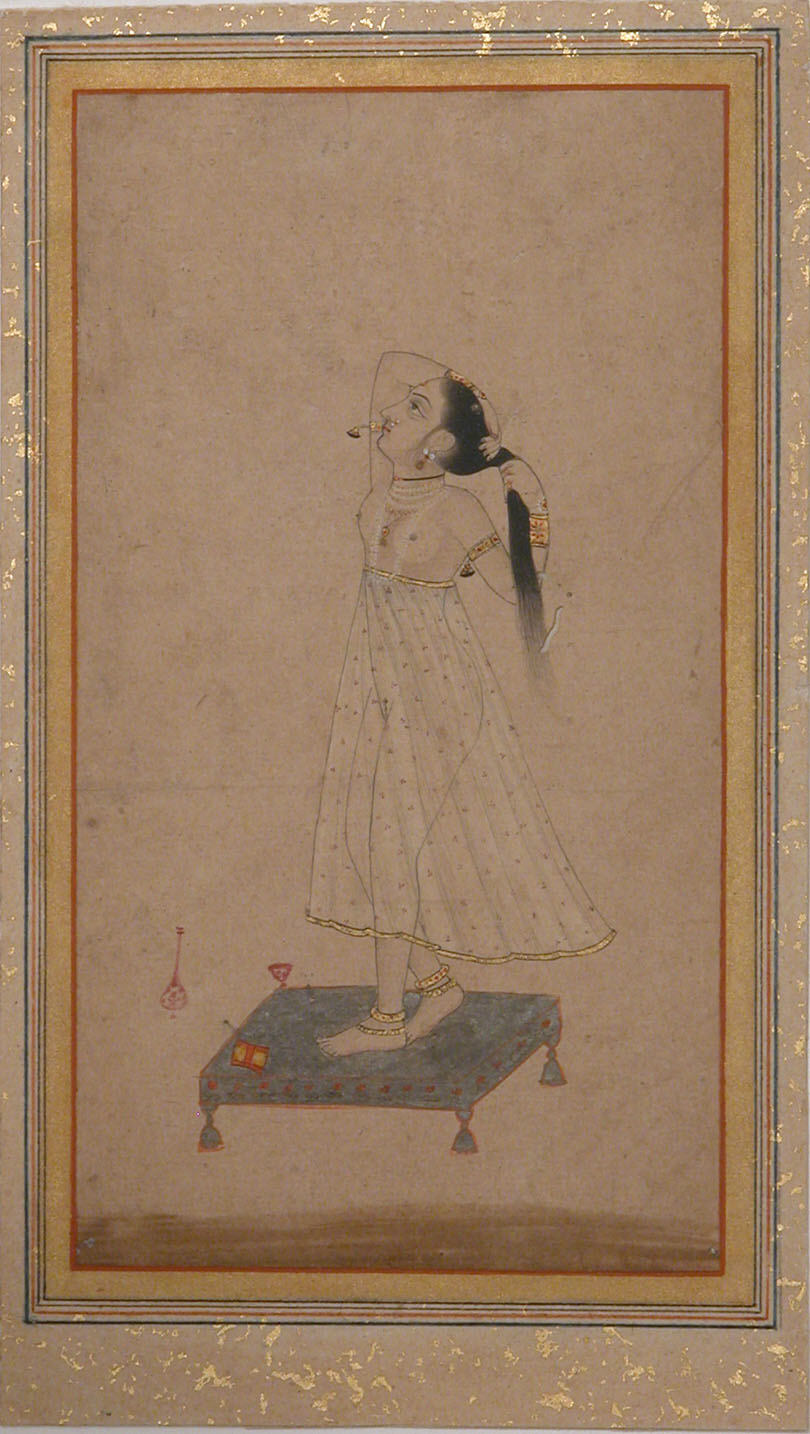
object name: illustrated single work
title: Lady Dressing Her Hair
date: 1767-1800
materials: gold, ink, paper, watercolor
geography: india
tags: profiles,women,dressing